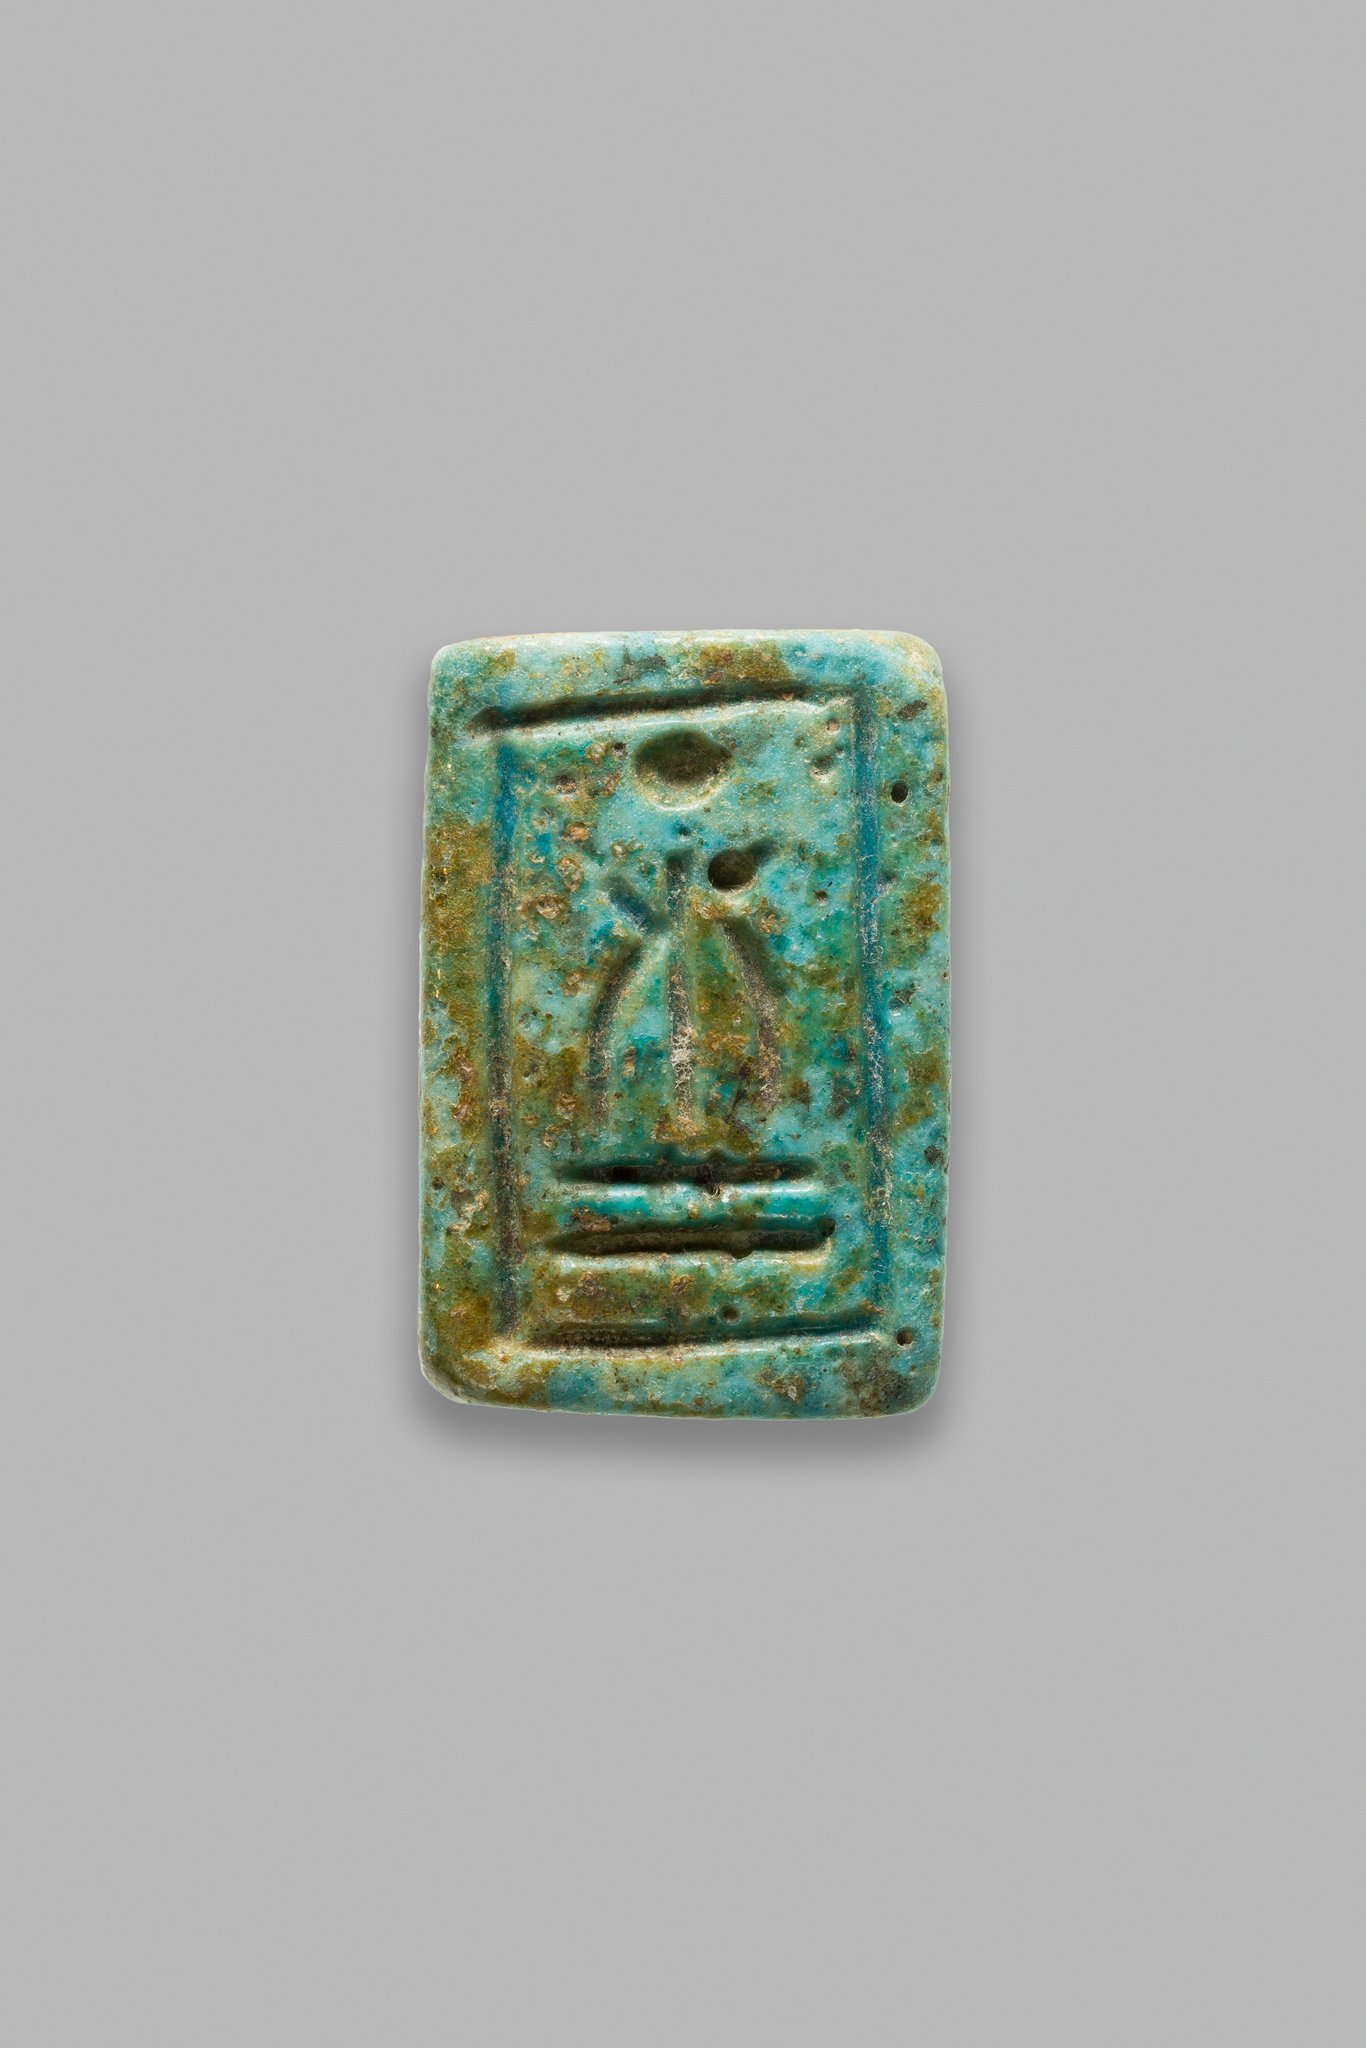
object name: foundation deposit plaque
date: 1153-1147 BCE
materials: faience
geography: egypt